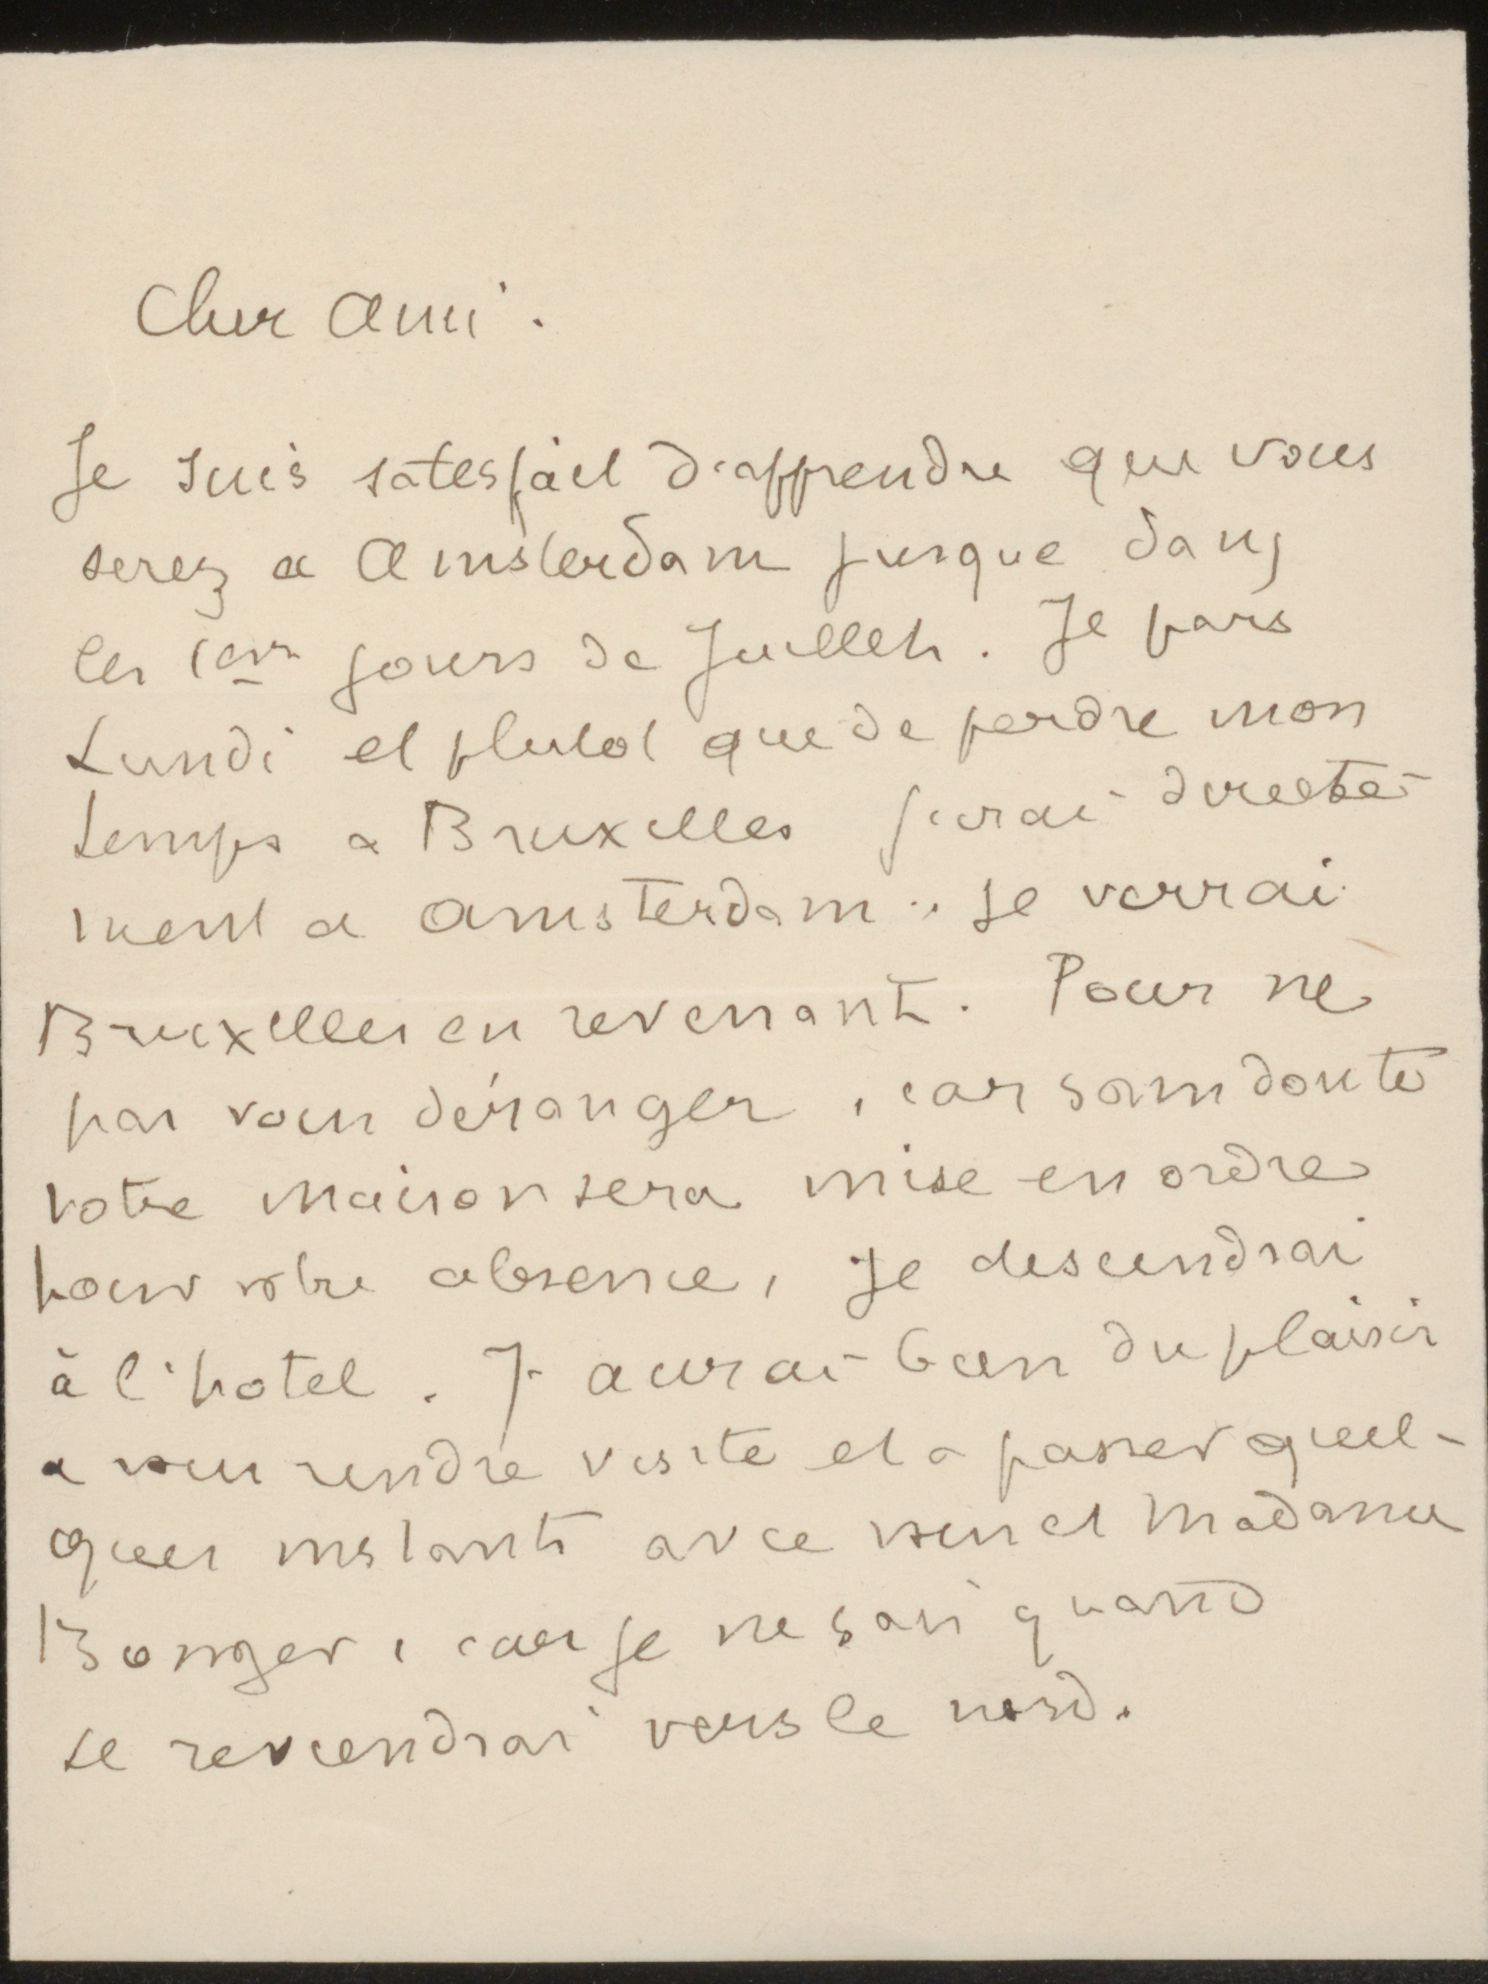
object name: letter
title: Brief aan Andries Bonger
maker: émile bernard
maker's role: print maker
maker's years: 1868-1941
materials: ink, paper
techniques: pen, writing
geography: paris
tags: amsterdam, andries bonger, brussels